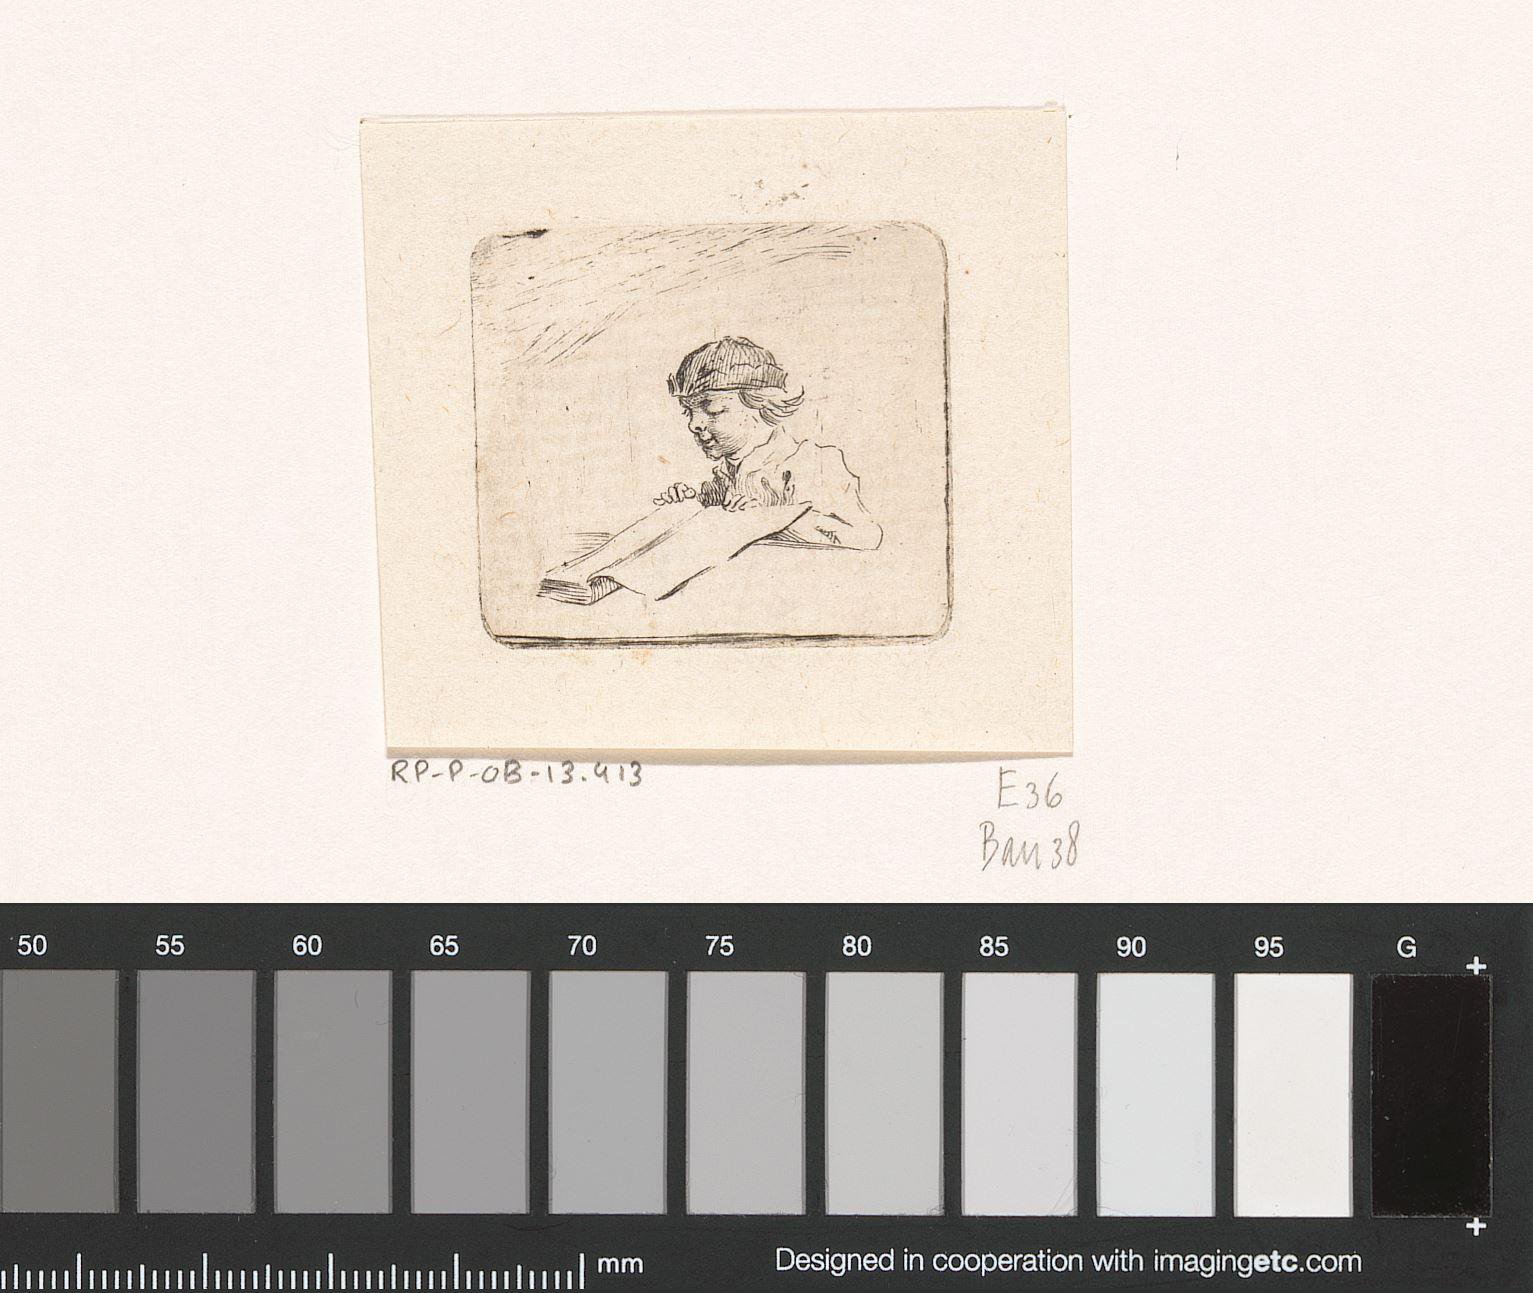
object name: print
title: Lezend kind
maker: daniel nikolaus chodowiecki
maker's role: draughtsman, print maker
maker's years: 1726-1801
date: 1764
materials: paper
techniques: etching, intaglio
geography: berlin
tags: reading, book - mm - book open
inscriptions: collector's mark: Lugt 2228